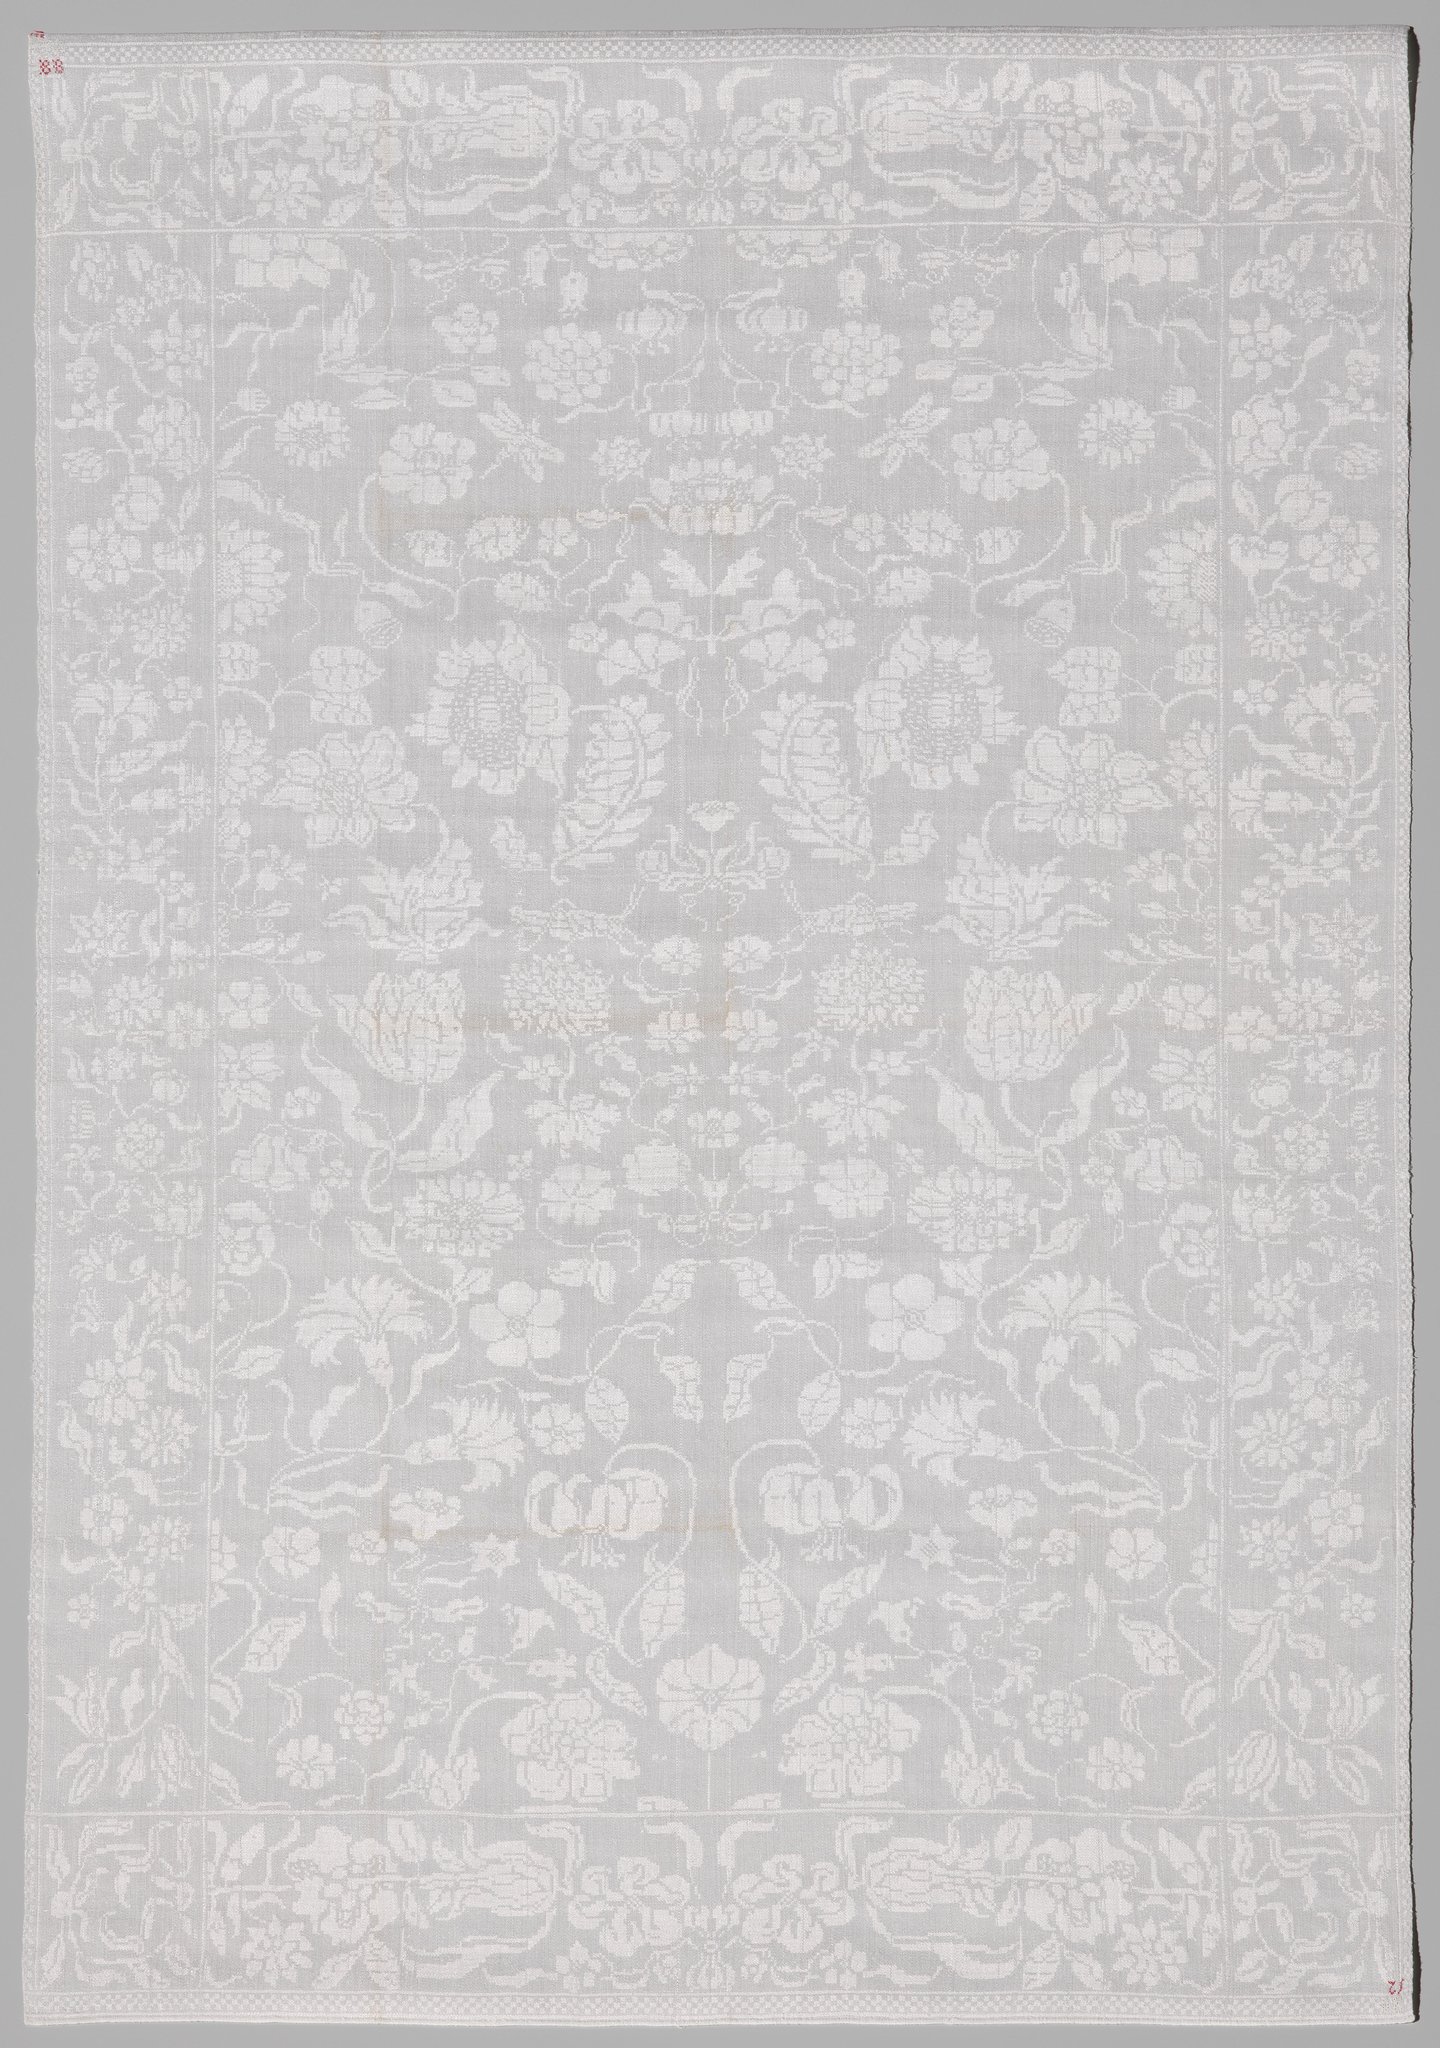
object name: napkin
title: Servet van linnendamast met een bloempatroon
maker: Anonymous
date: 1670-1680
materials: linen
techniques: damask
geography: flanders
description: Wit linnendamasten servet met gestrooide bloemen. Gemerkt met bindgaatjes "OD" en "24", in rode kruissteek "12" en "BB".